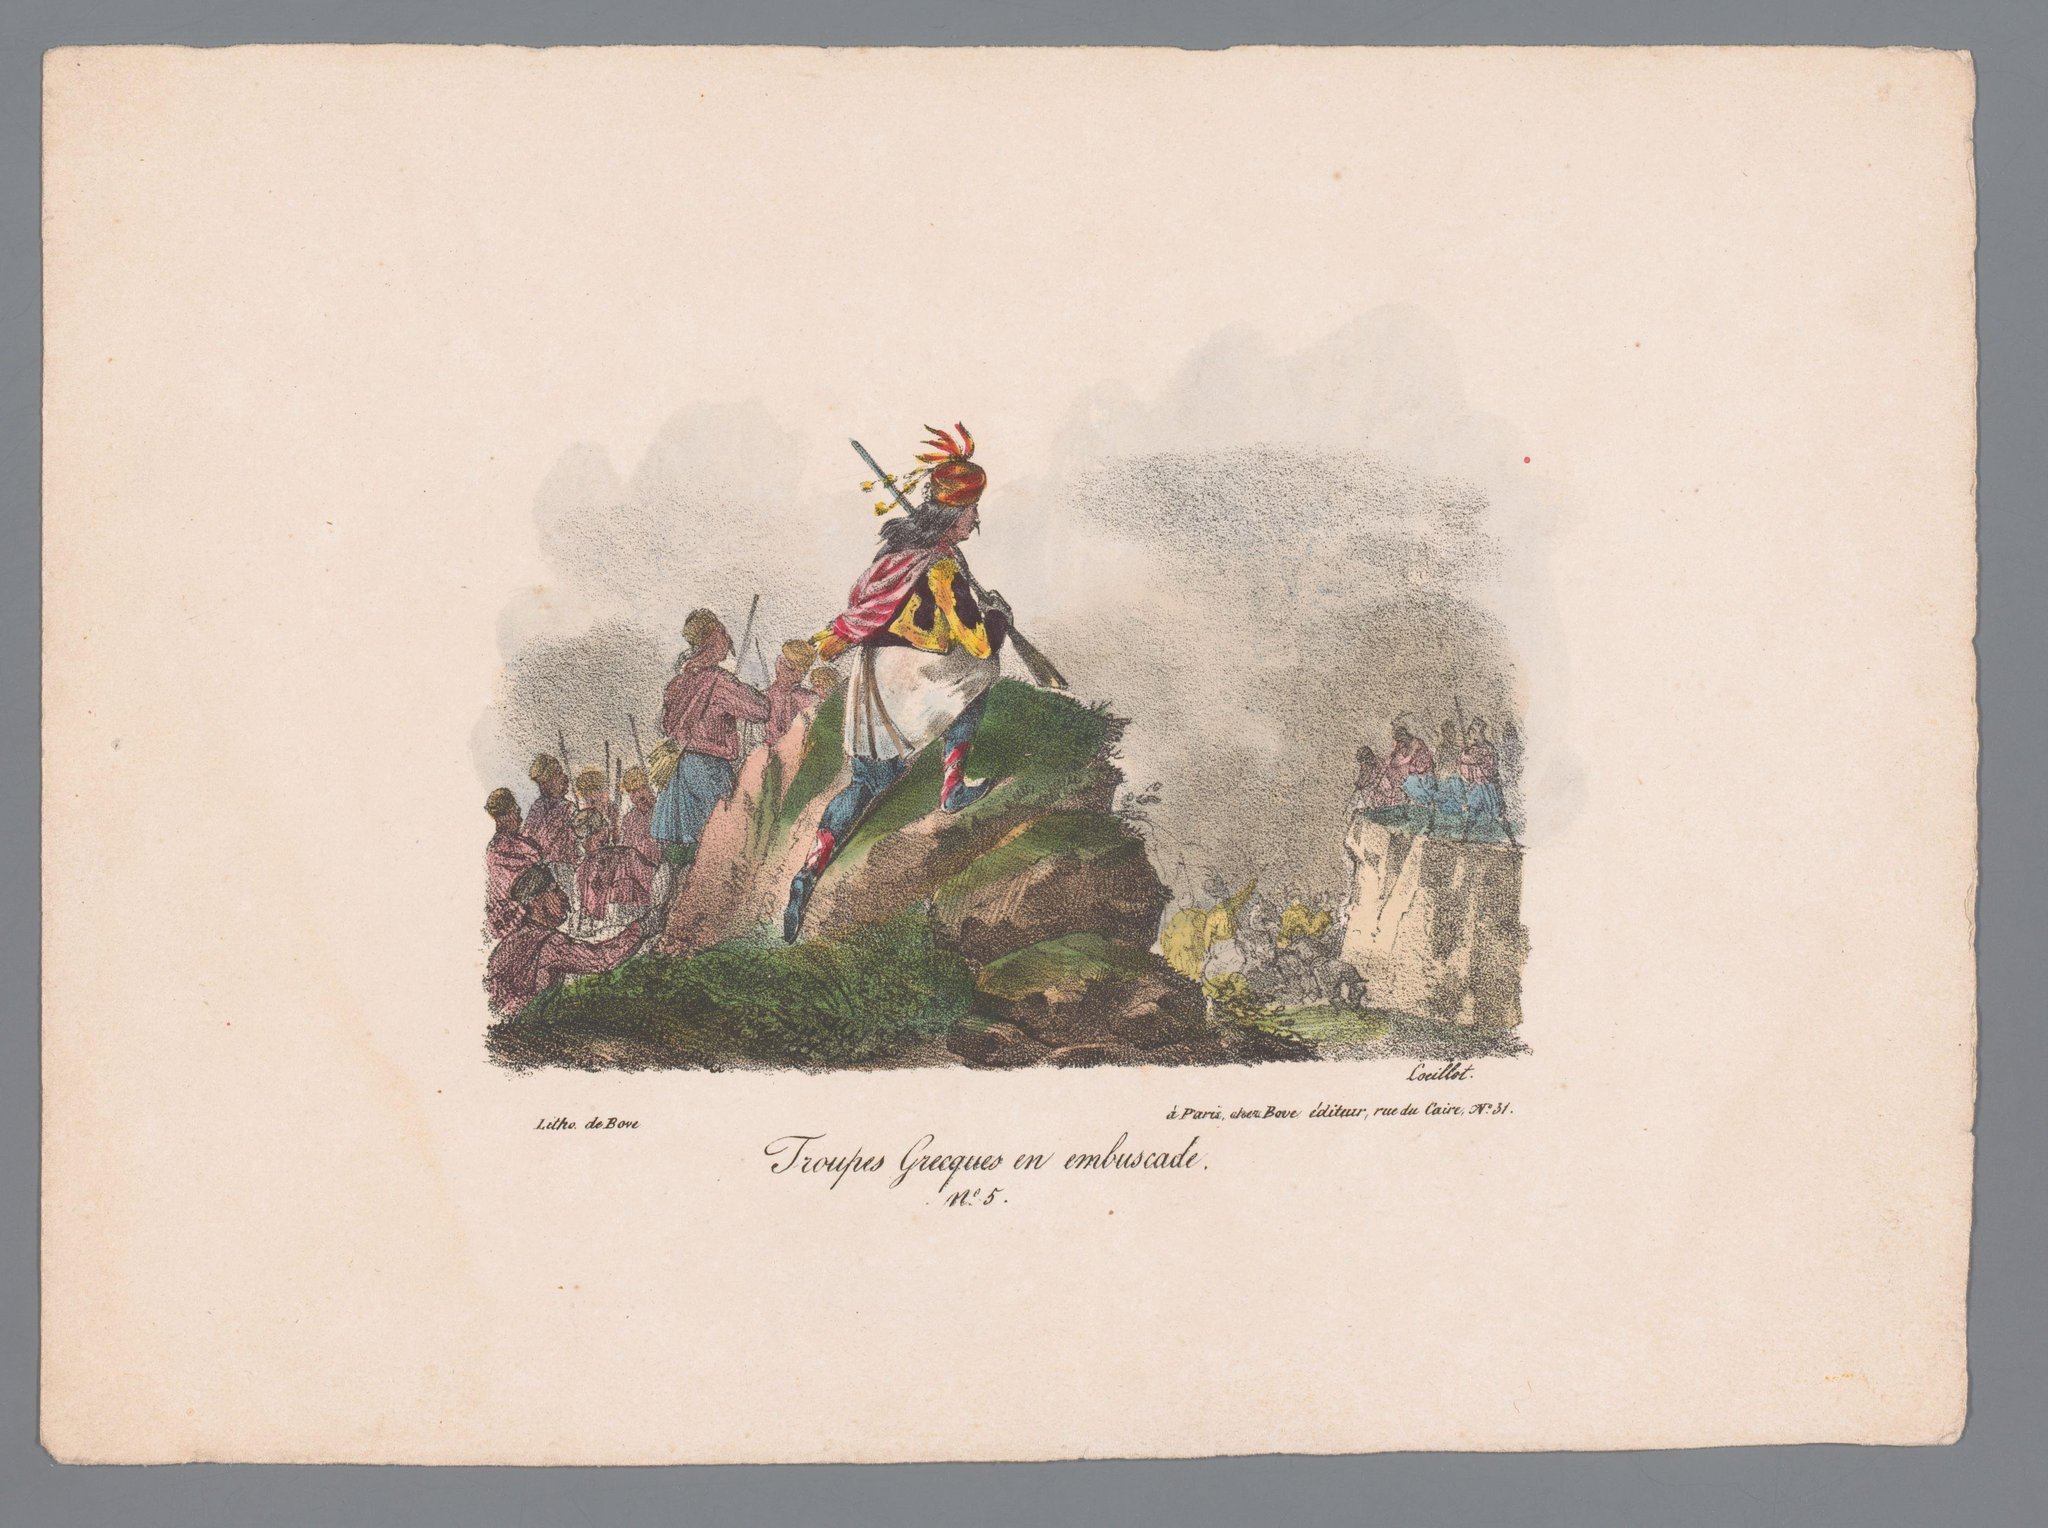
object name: print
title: Griekse troepen in hinderlaag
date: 1829-1835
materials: paper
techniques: hand coloring, lithograph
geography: paris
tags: weapons, surprise attack (from ambush), (military) uniforms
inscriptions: collector's mark: Lugt 2228